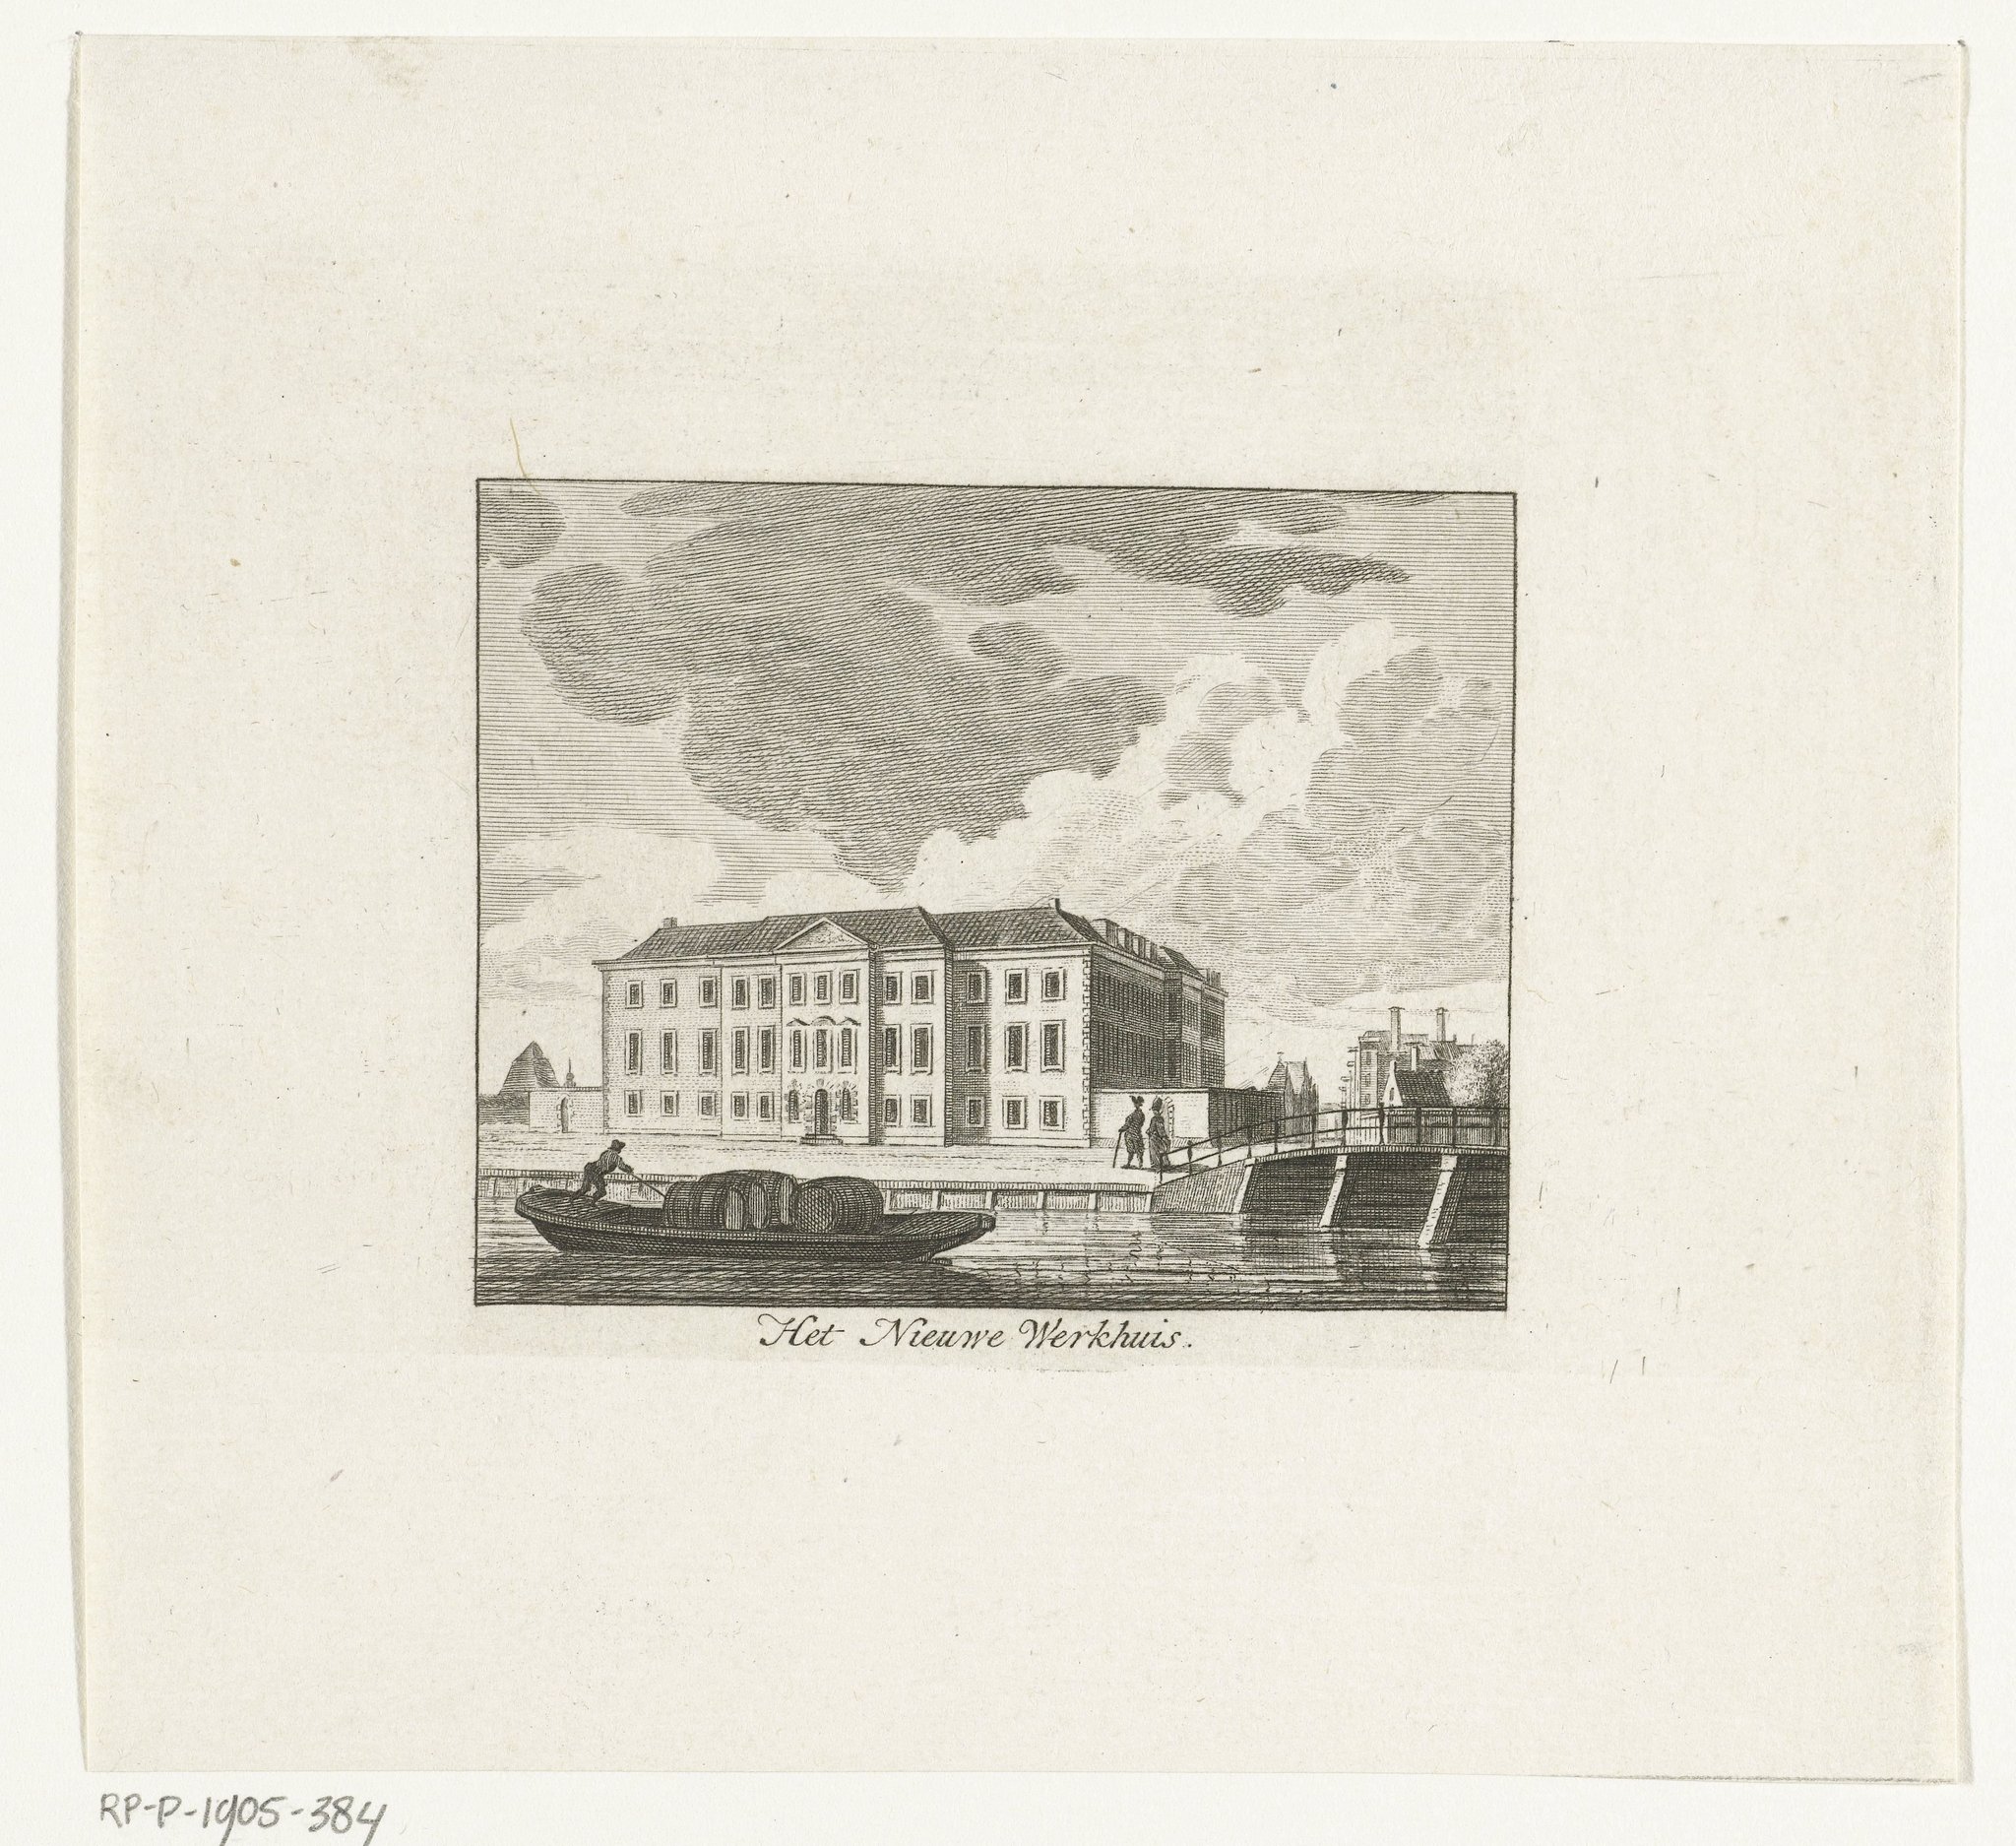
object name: print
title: Gezicht op het Nieuwe Werkhuis te Amsterdam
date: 1782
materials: paper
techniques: etching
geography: northern netherlands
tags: spin- en nieuwe werkhuis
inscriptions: collector's mark: Lugt 2228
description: Prent mogelijk naar tekening van Hendrik Keun.